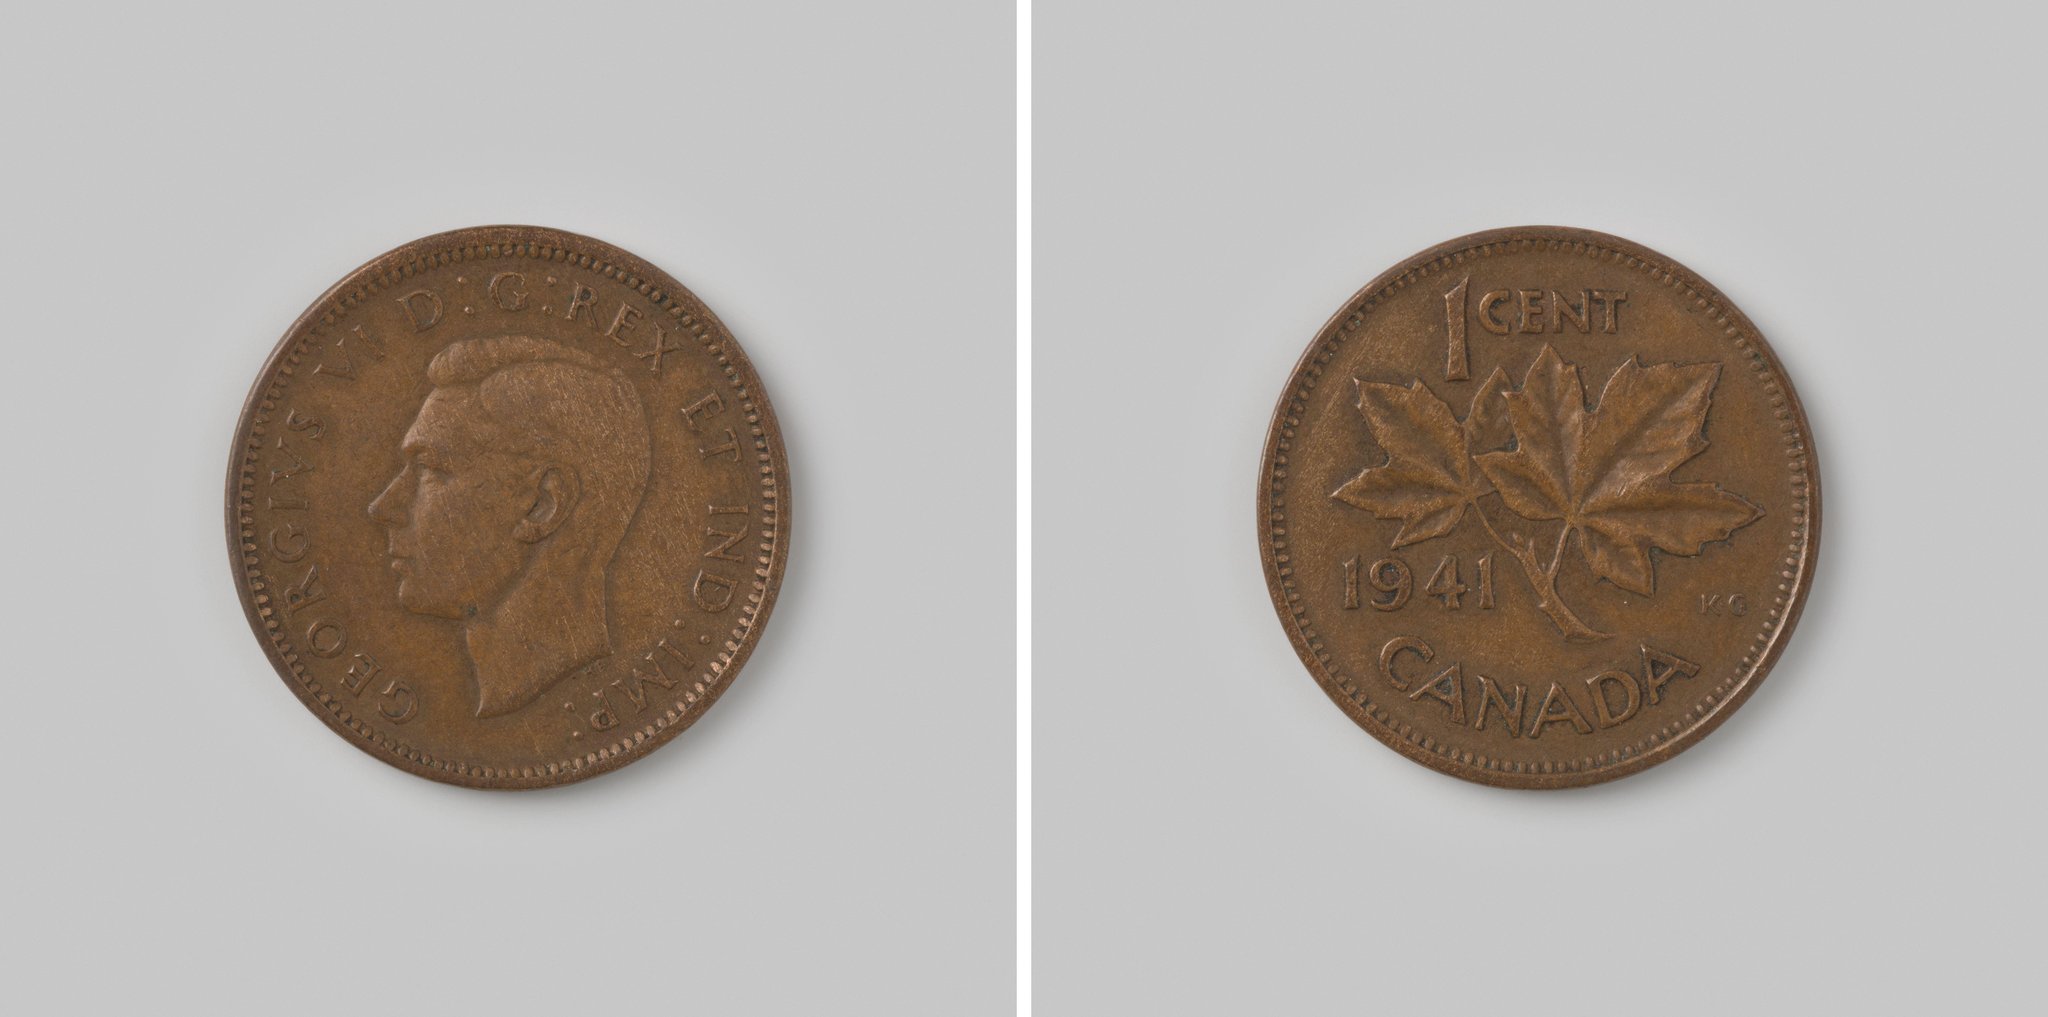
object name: coin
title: Canada, cent, 1944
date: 1944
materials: bronze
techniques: striking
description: Bronzen munt. Voorzijde: hoofd van George VI naar links. Keerzijde: twee vervlochten esdoorn-bladeren.Daarboven waarde-aanduiding en links daaronder jaartal, waaronder lands-aanduiding. Gladde rand.